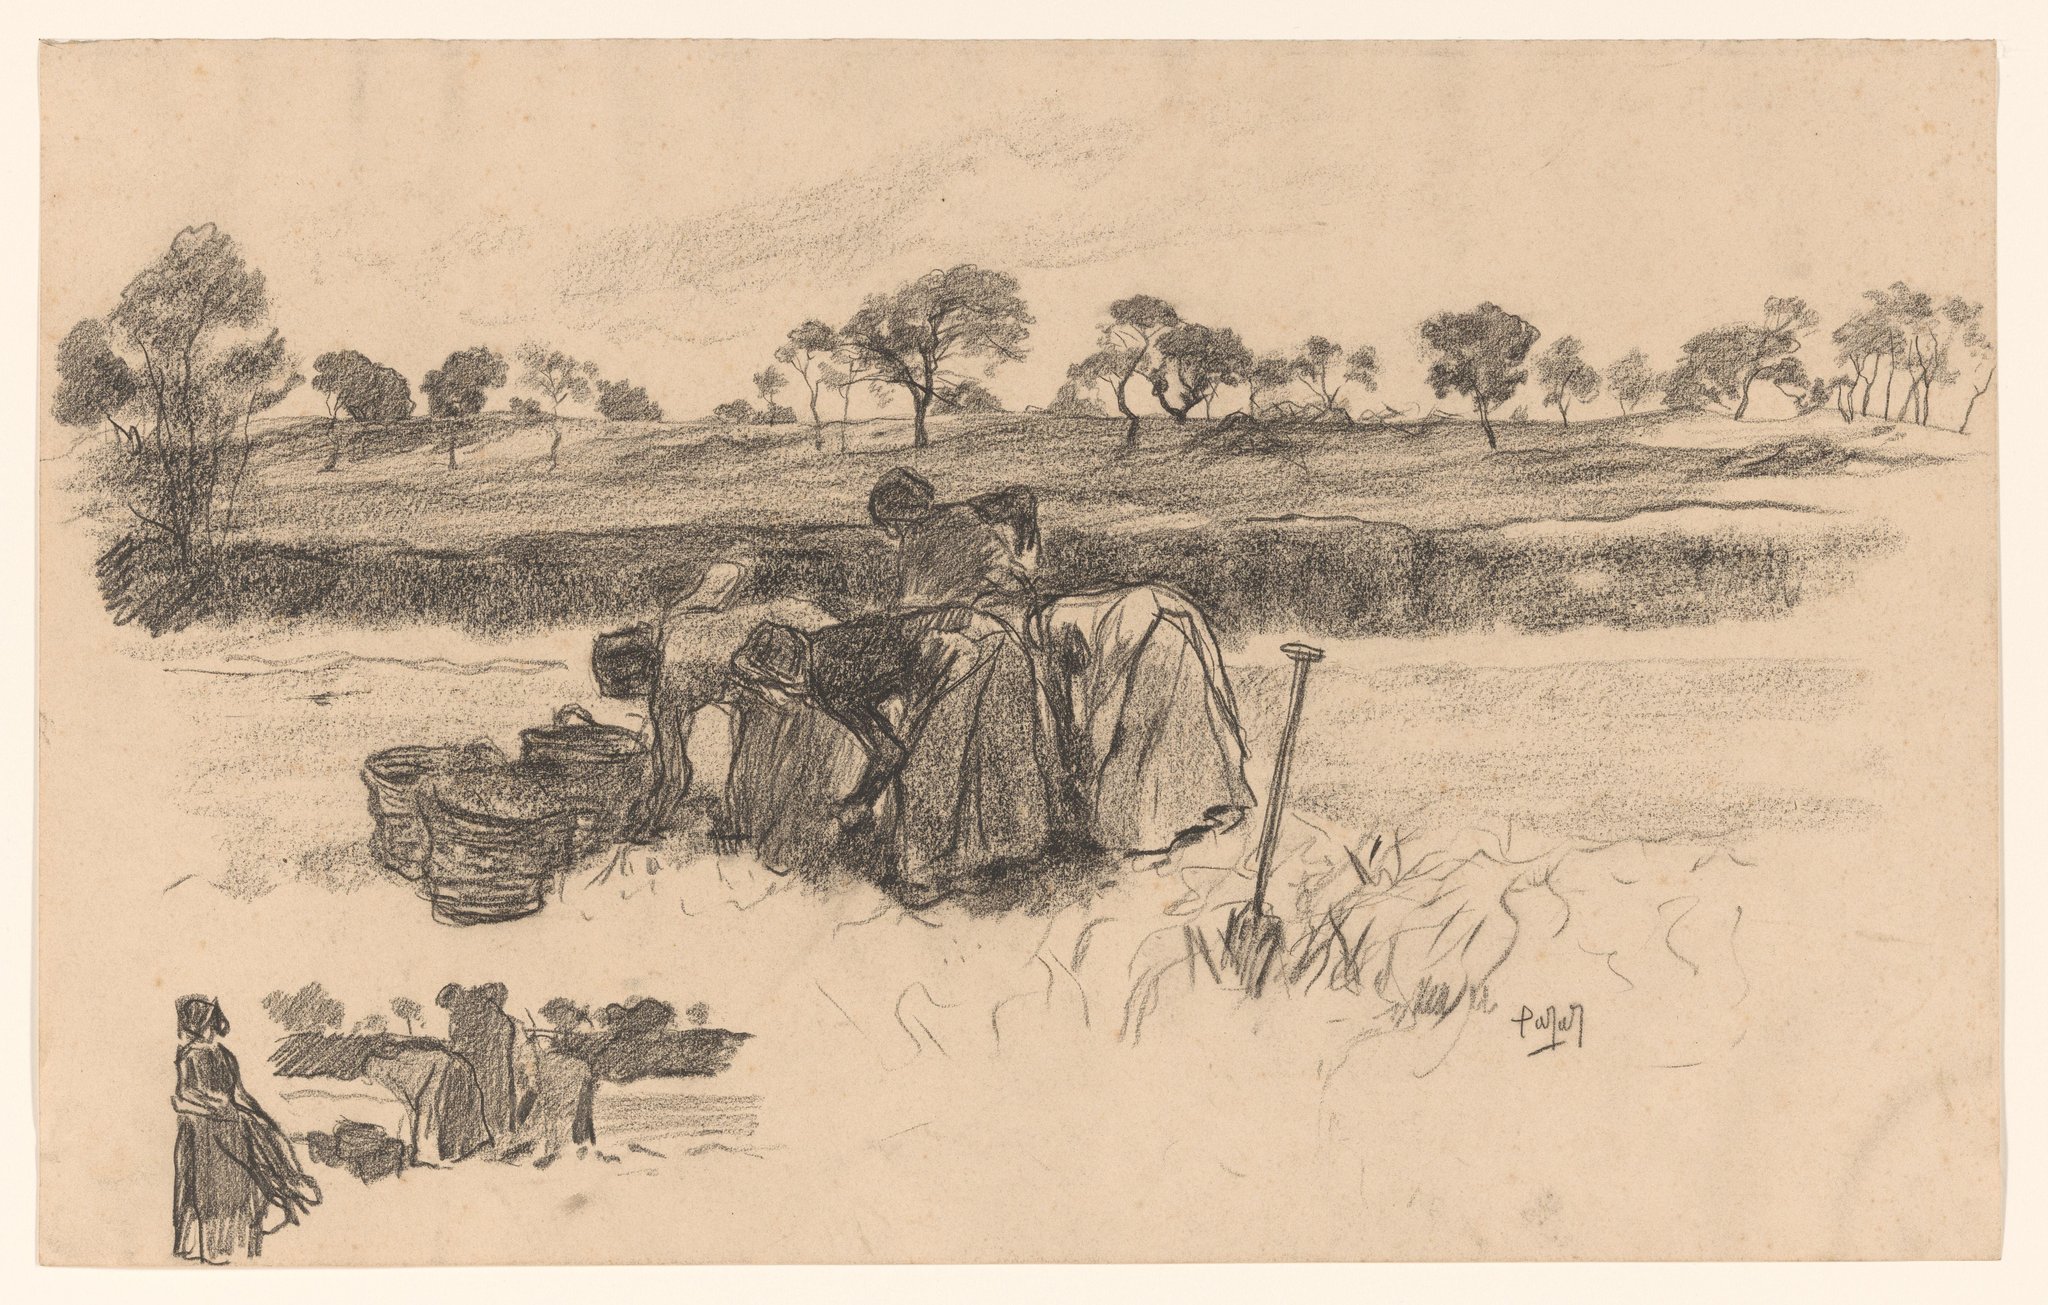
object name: drawing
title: Werkende vrouwen op de akker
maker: pieter de josselin de jong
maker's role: draughtsman, painter, print maker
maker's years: 1861-1906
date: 1871-1906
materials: chalk, paper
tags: potatoes, reaping, picking, mowing ~ harvest